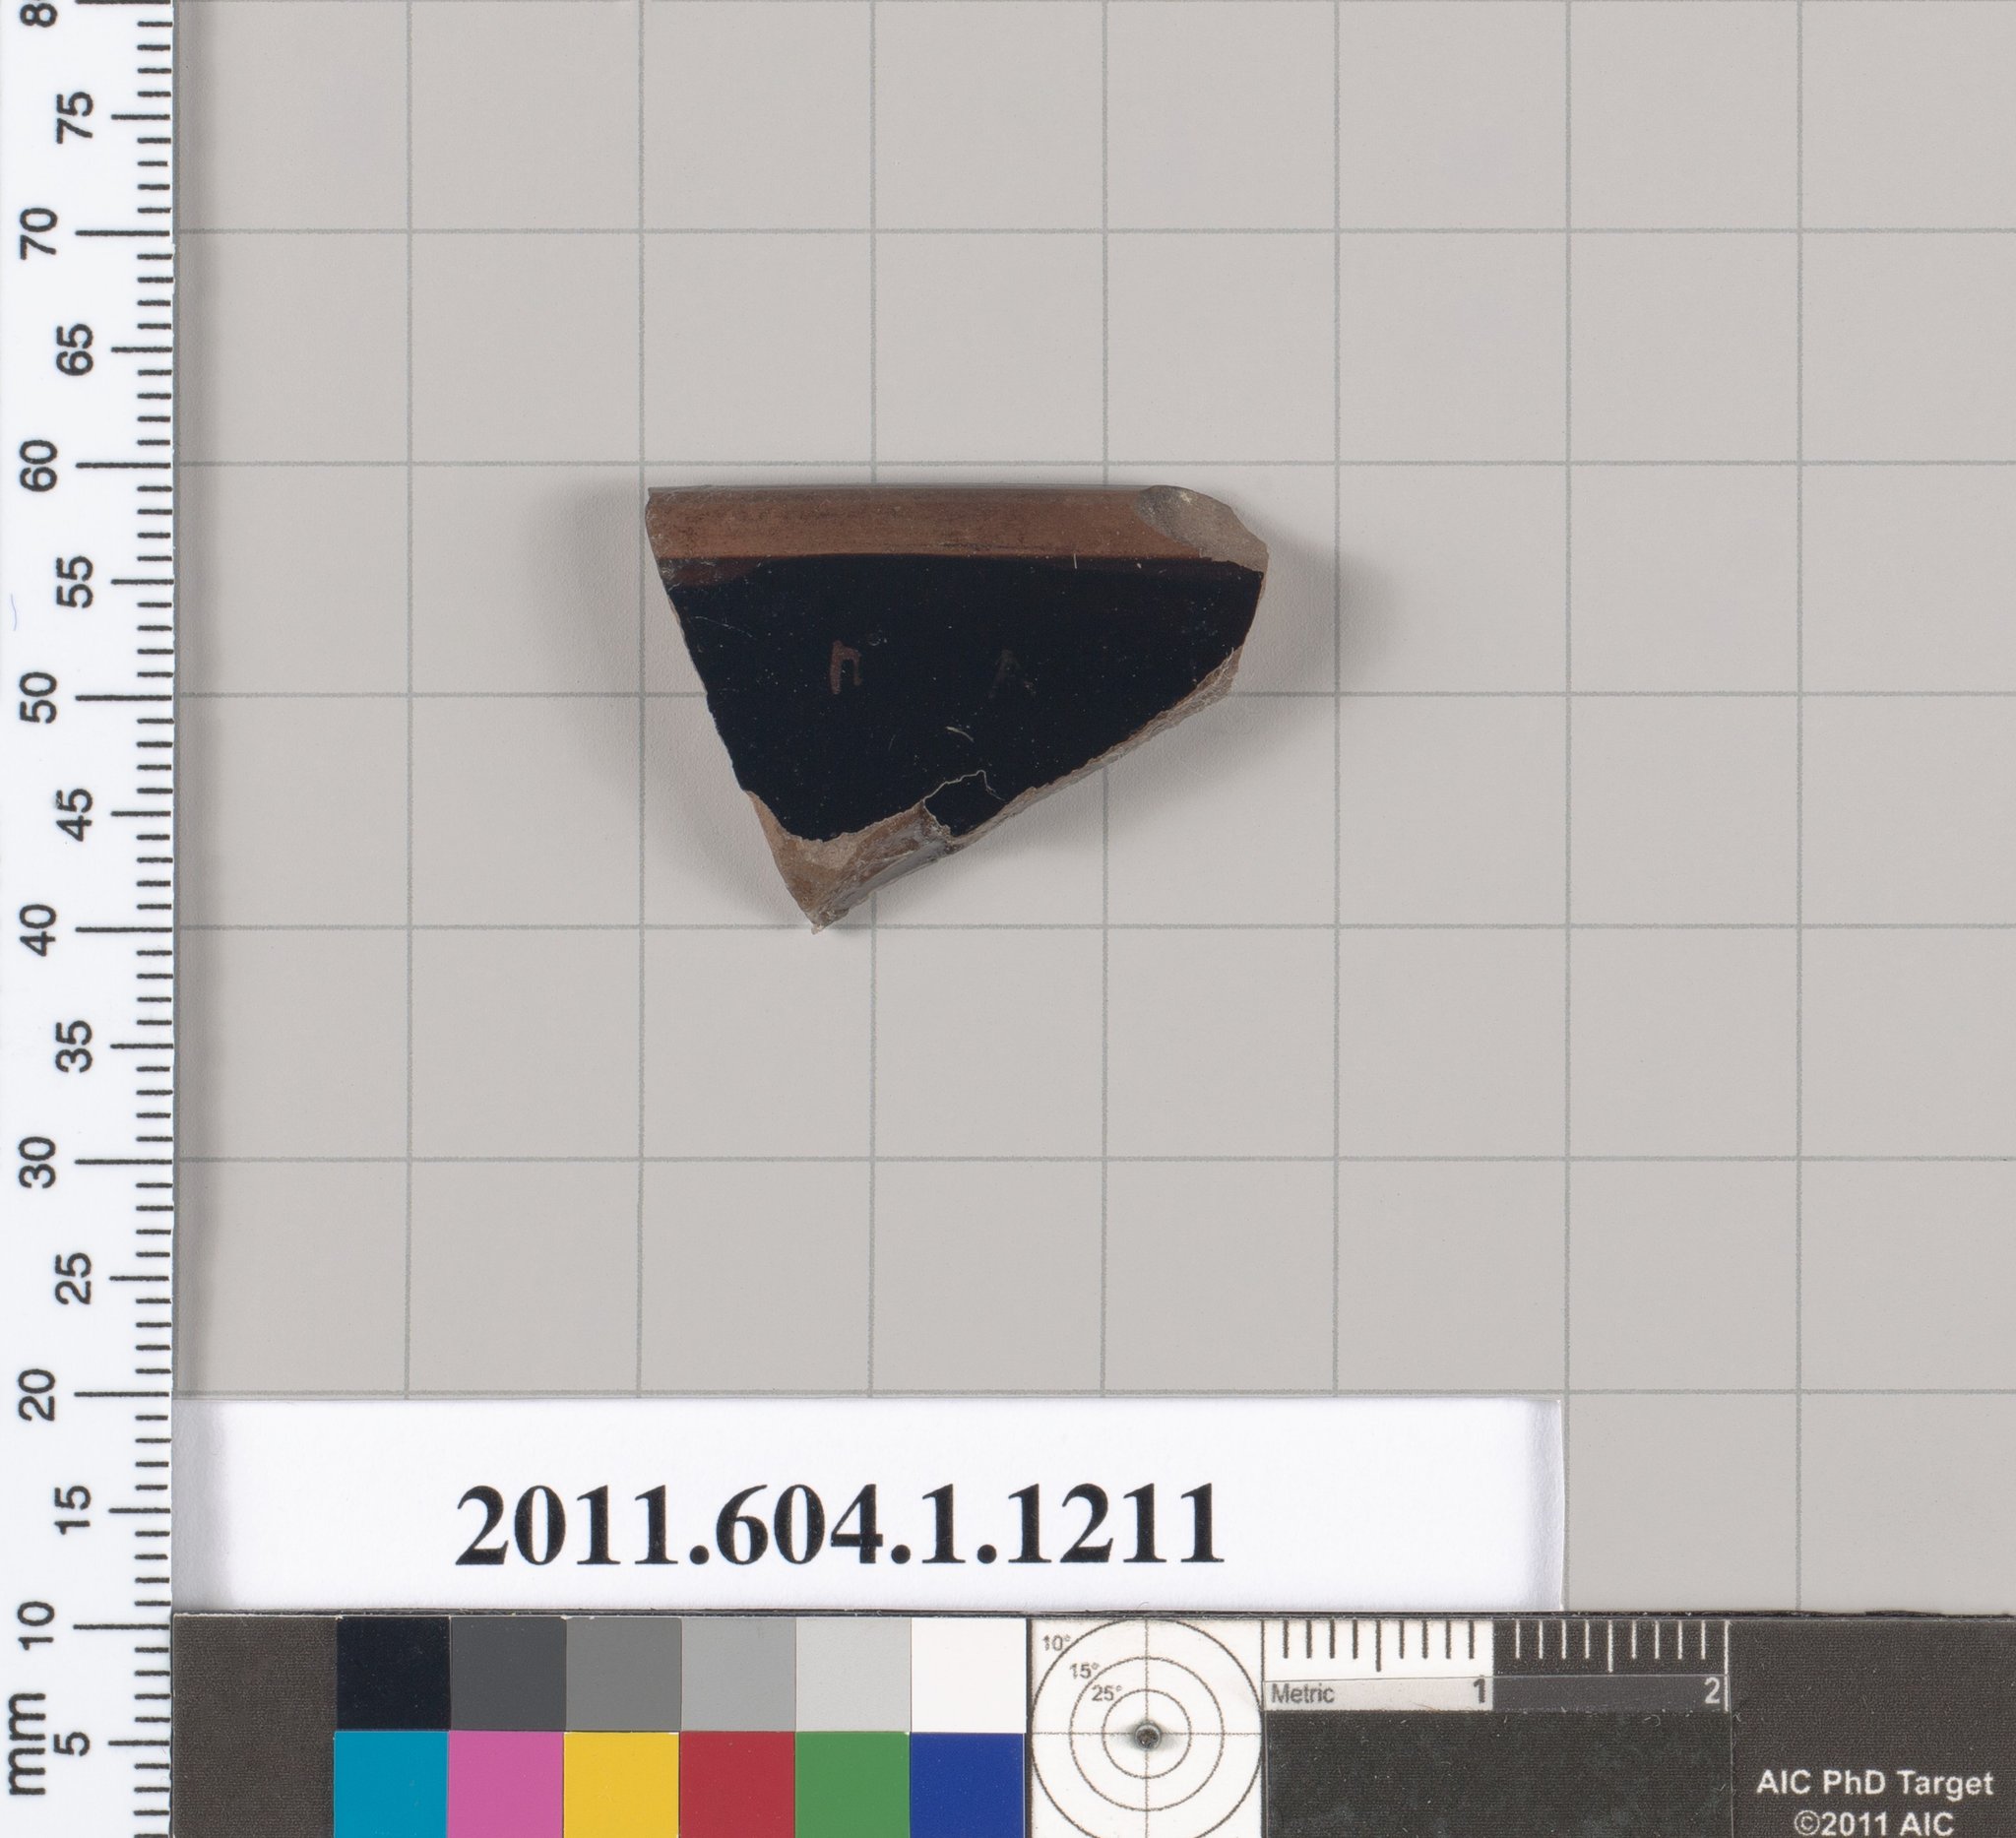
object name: kylix fragment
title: Terracotta rim fragment of a kylix (drinking cup)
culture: greek, attic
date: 490-480 BCE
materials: terracotta